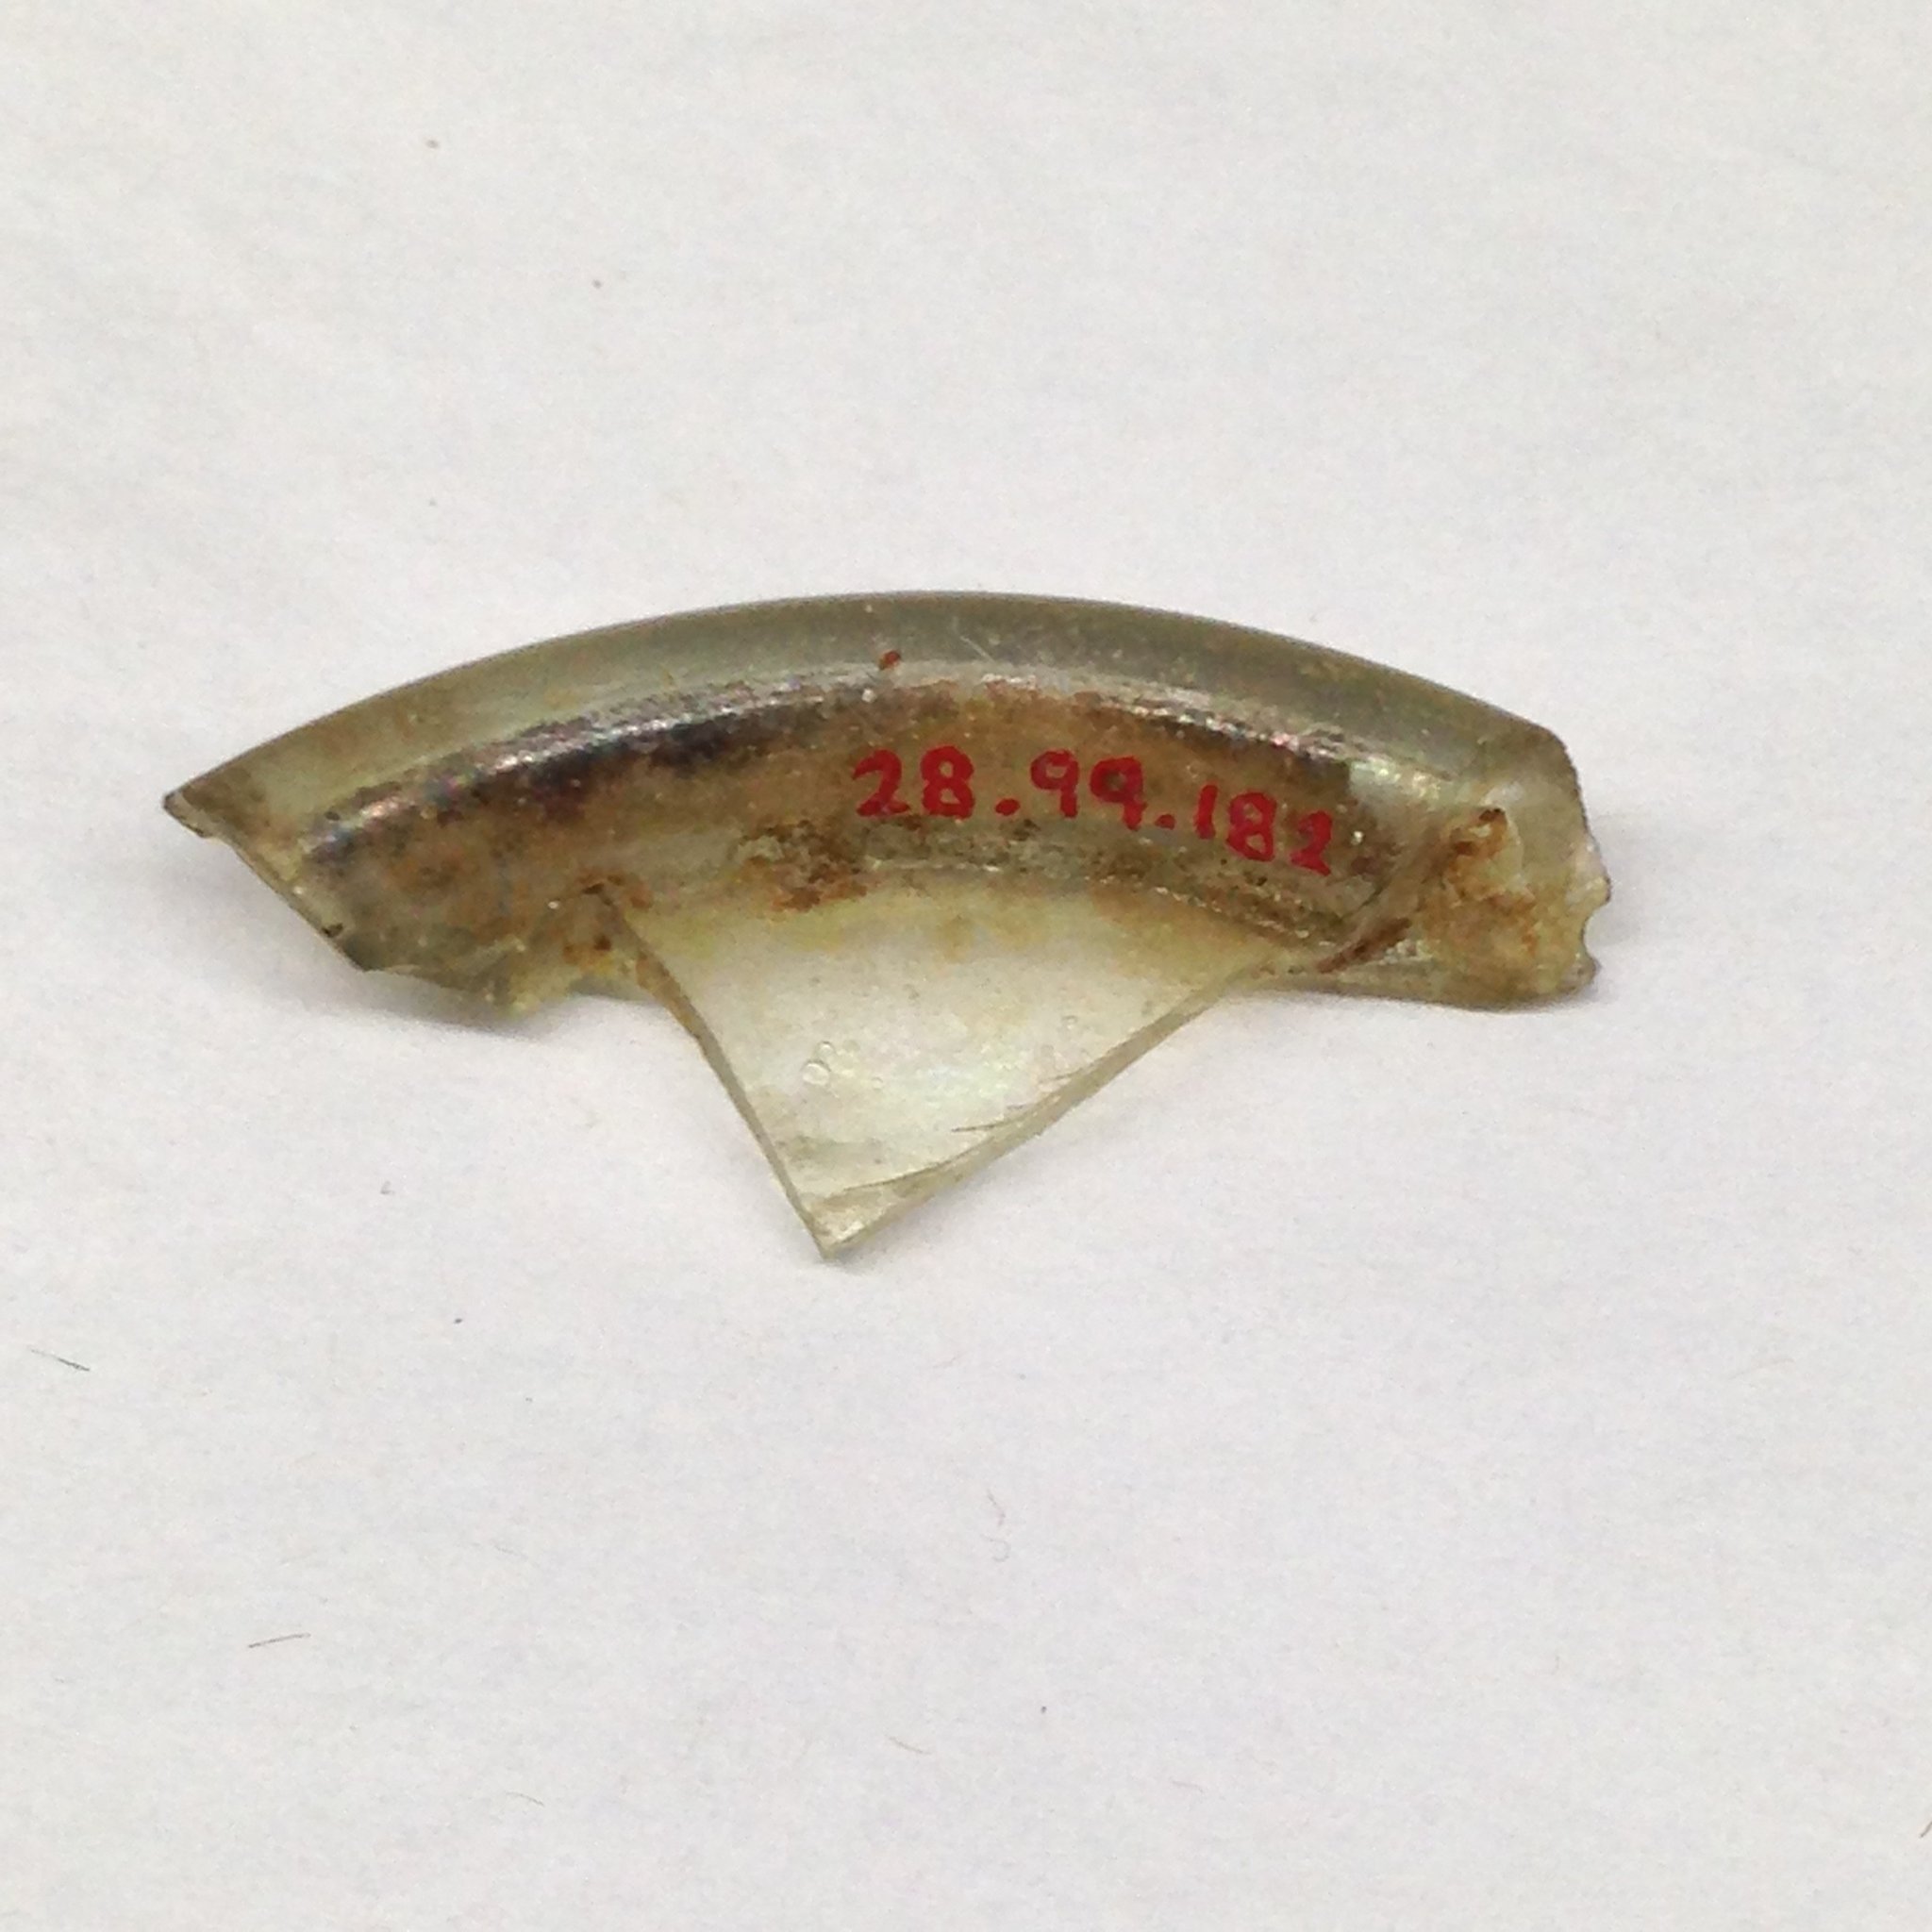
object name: fragment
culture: european or middle eastern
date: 1150-1250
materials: ceramic, glass